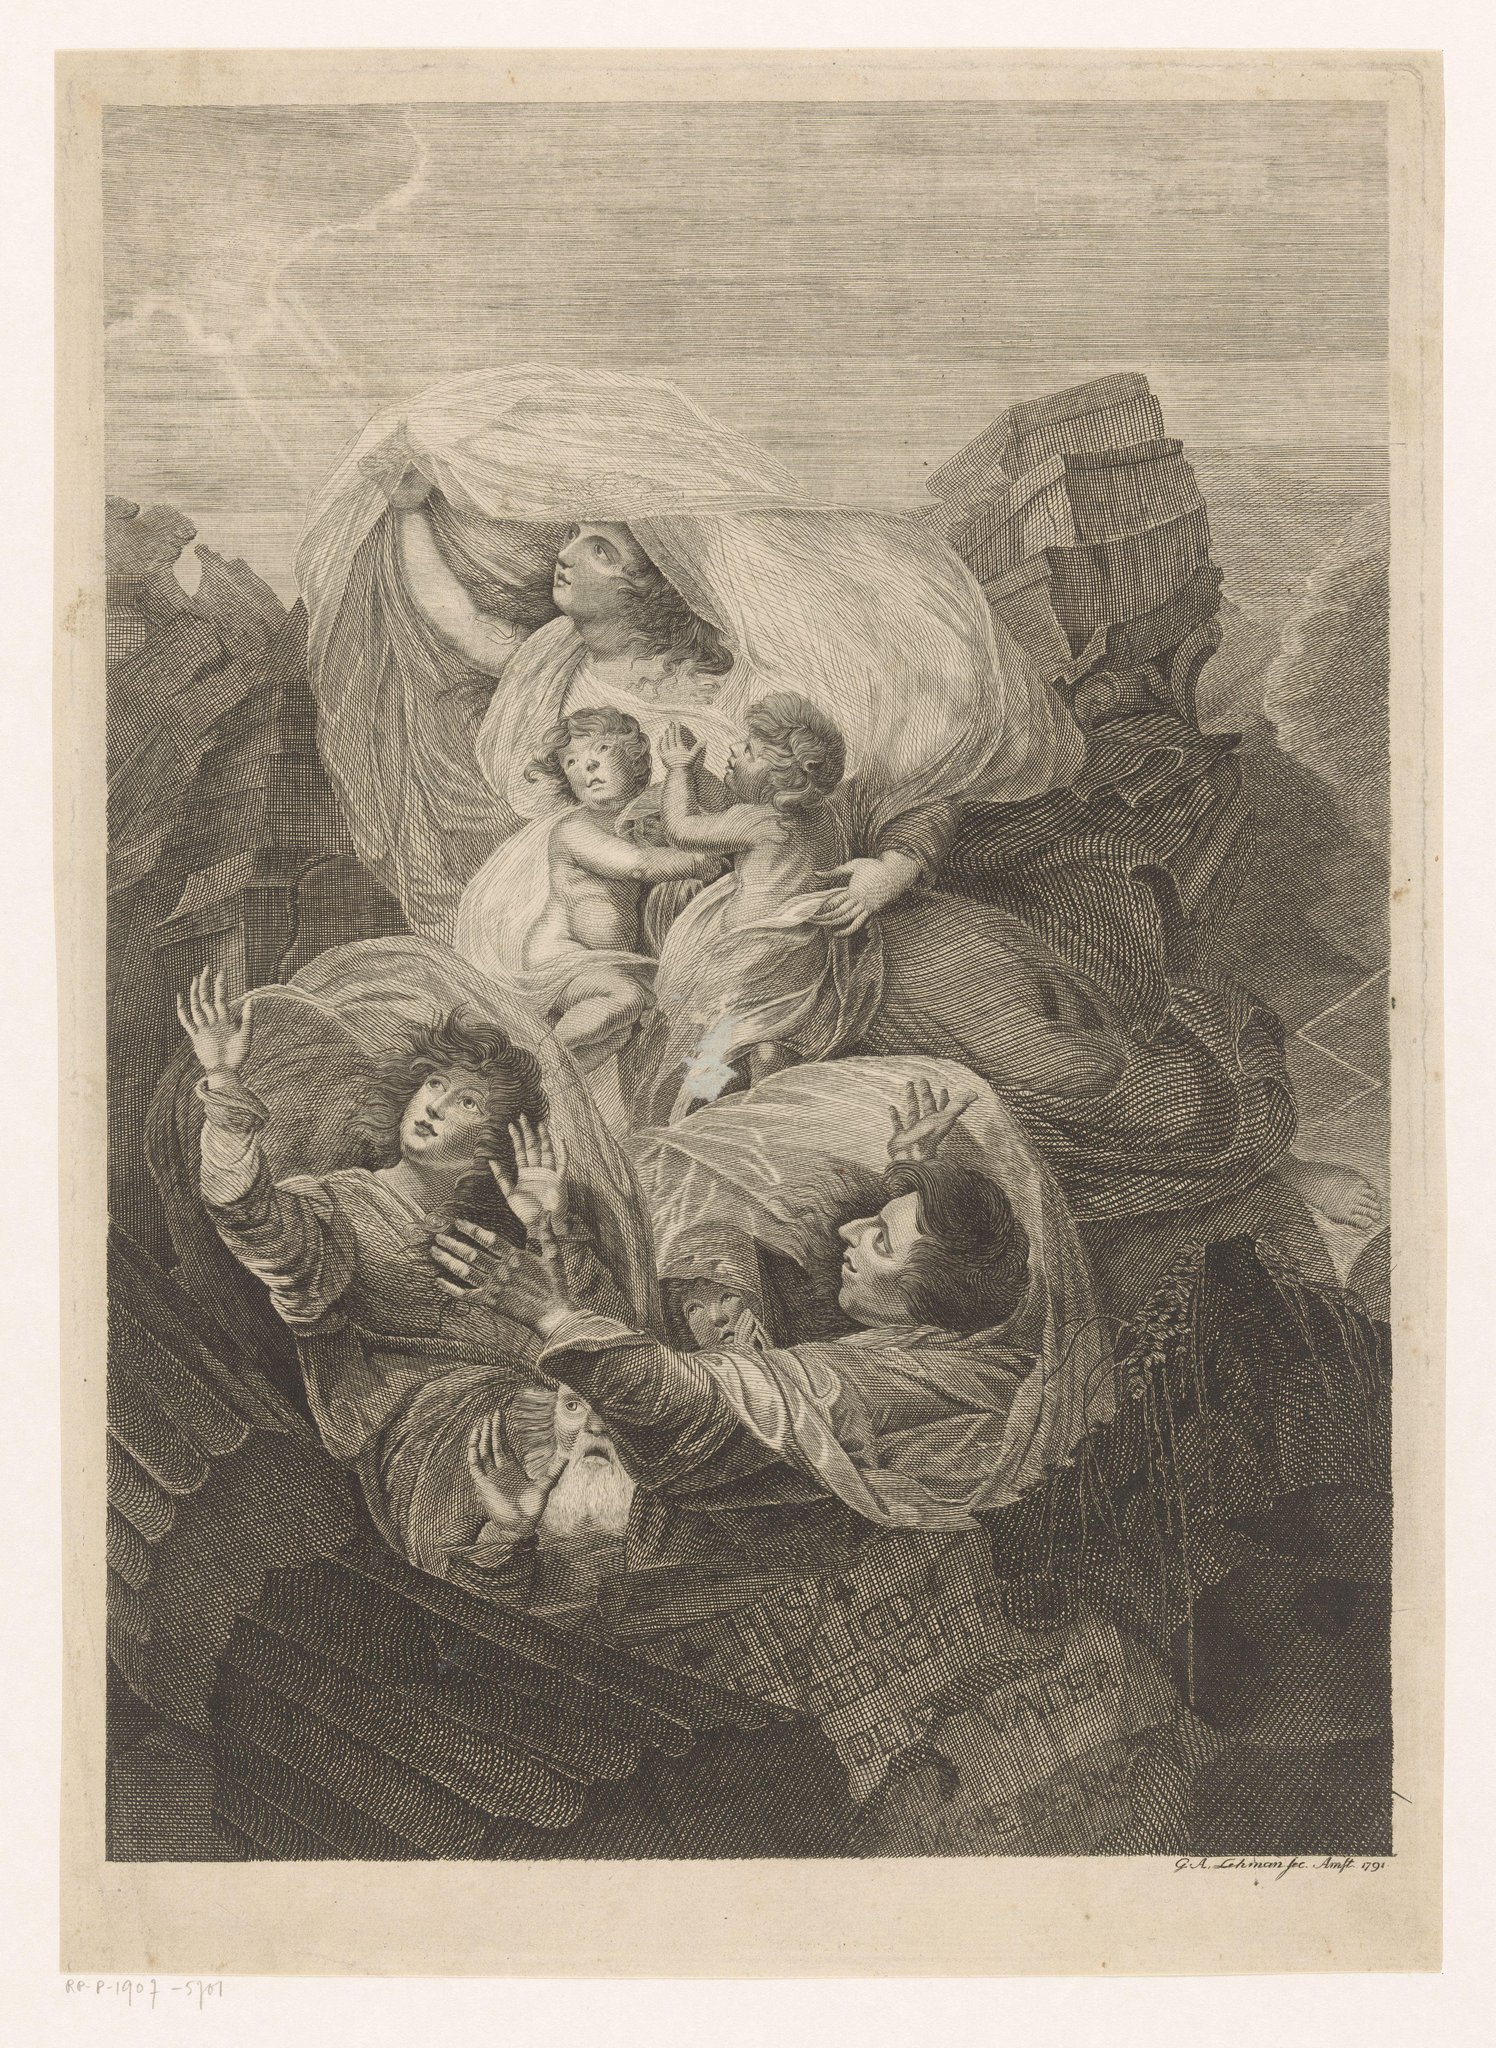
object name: print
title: Allegorische voorstelling van familie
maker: gottfried arnold lehman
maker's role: print maker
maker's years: 1770-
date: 1791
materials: paper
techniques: engraving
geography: amsterdam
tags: abstract ideas and concepts (+ allegorical scene, i.e. two or more personifications involved in an action), family life, collapsing building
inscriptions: collector's mark: Lugt 2760, collector's mark: Lugt 2228